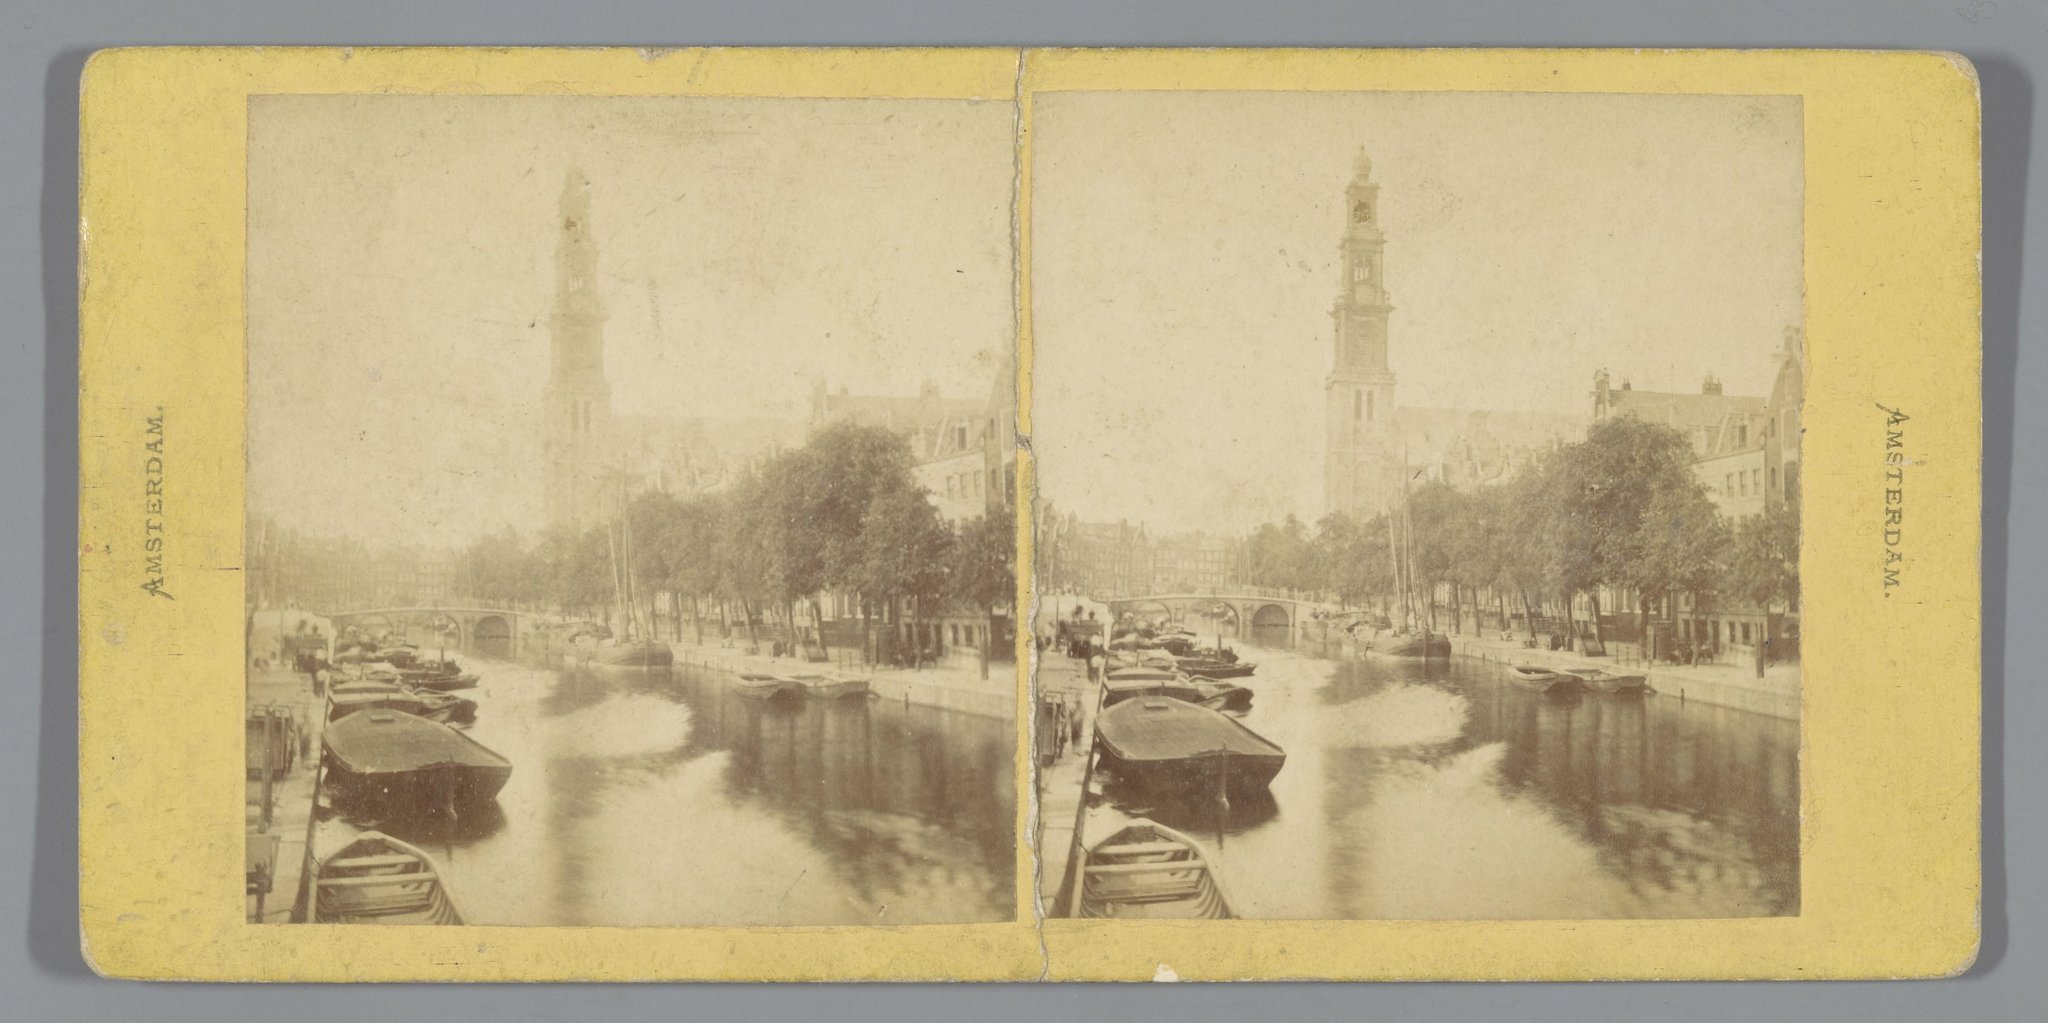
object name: stereograph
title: Gezicht op de Prinsengracht met de Westerkerk, Amsterdam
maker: Anonymous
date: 1868-1890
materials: cardboard, paper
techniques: albumen print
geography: amsterdam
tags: church (exterior), canals, waters (in city)